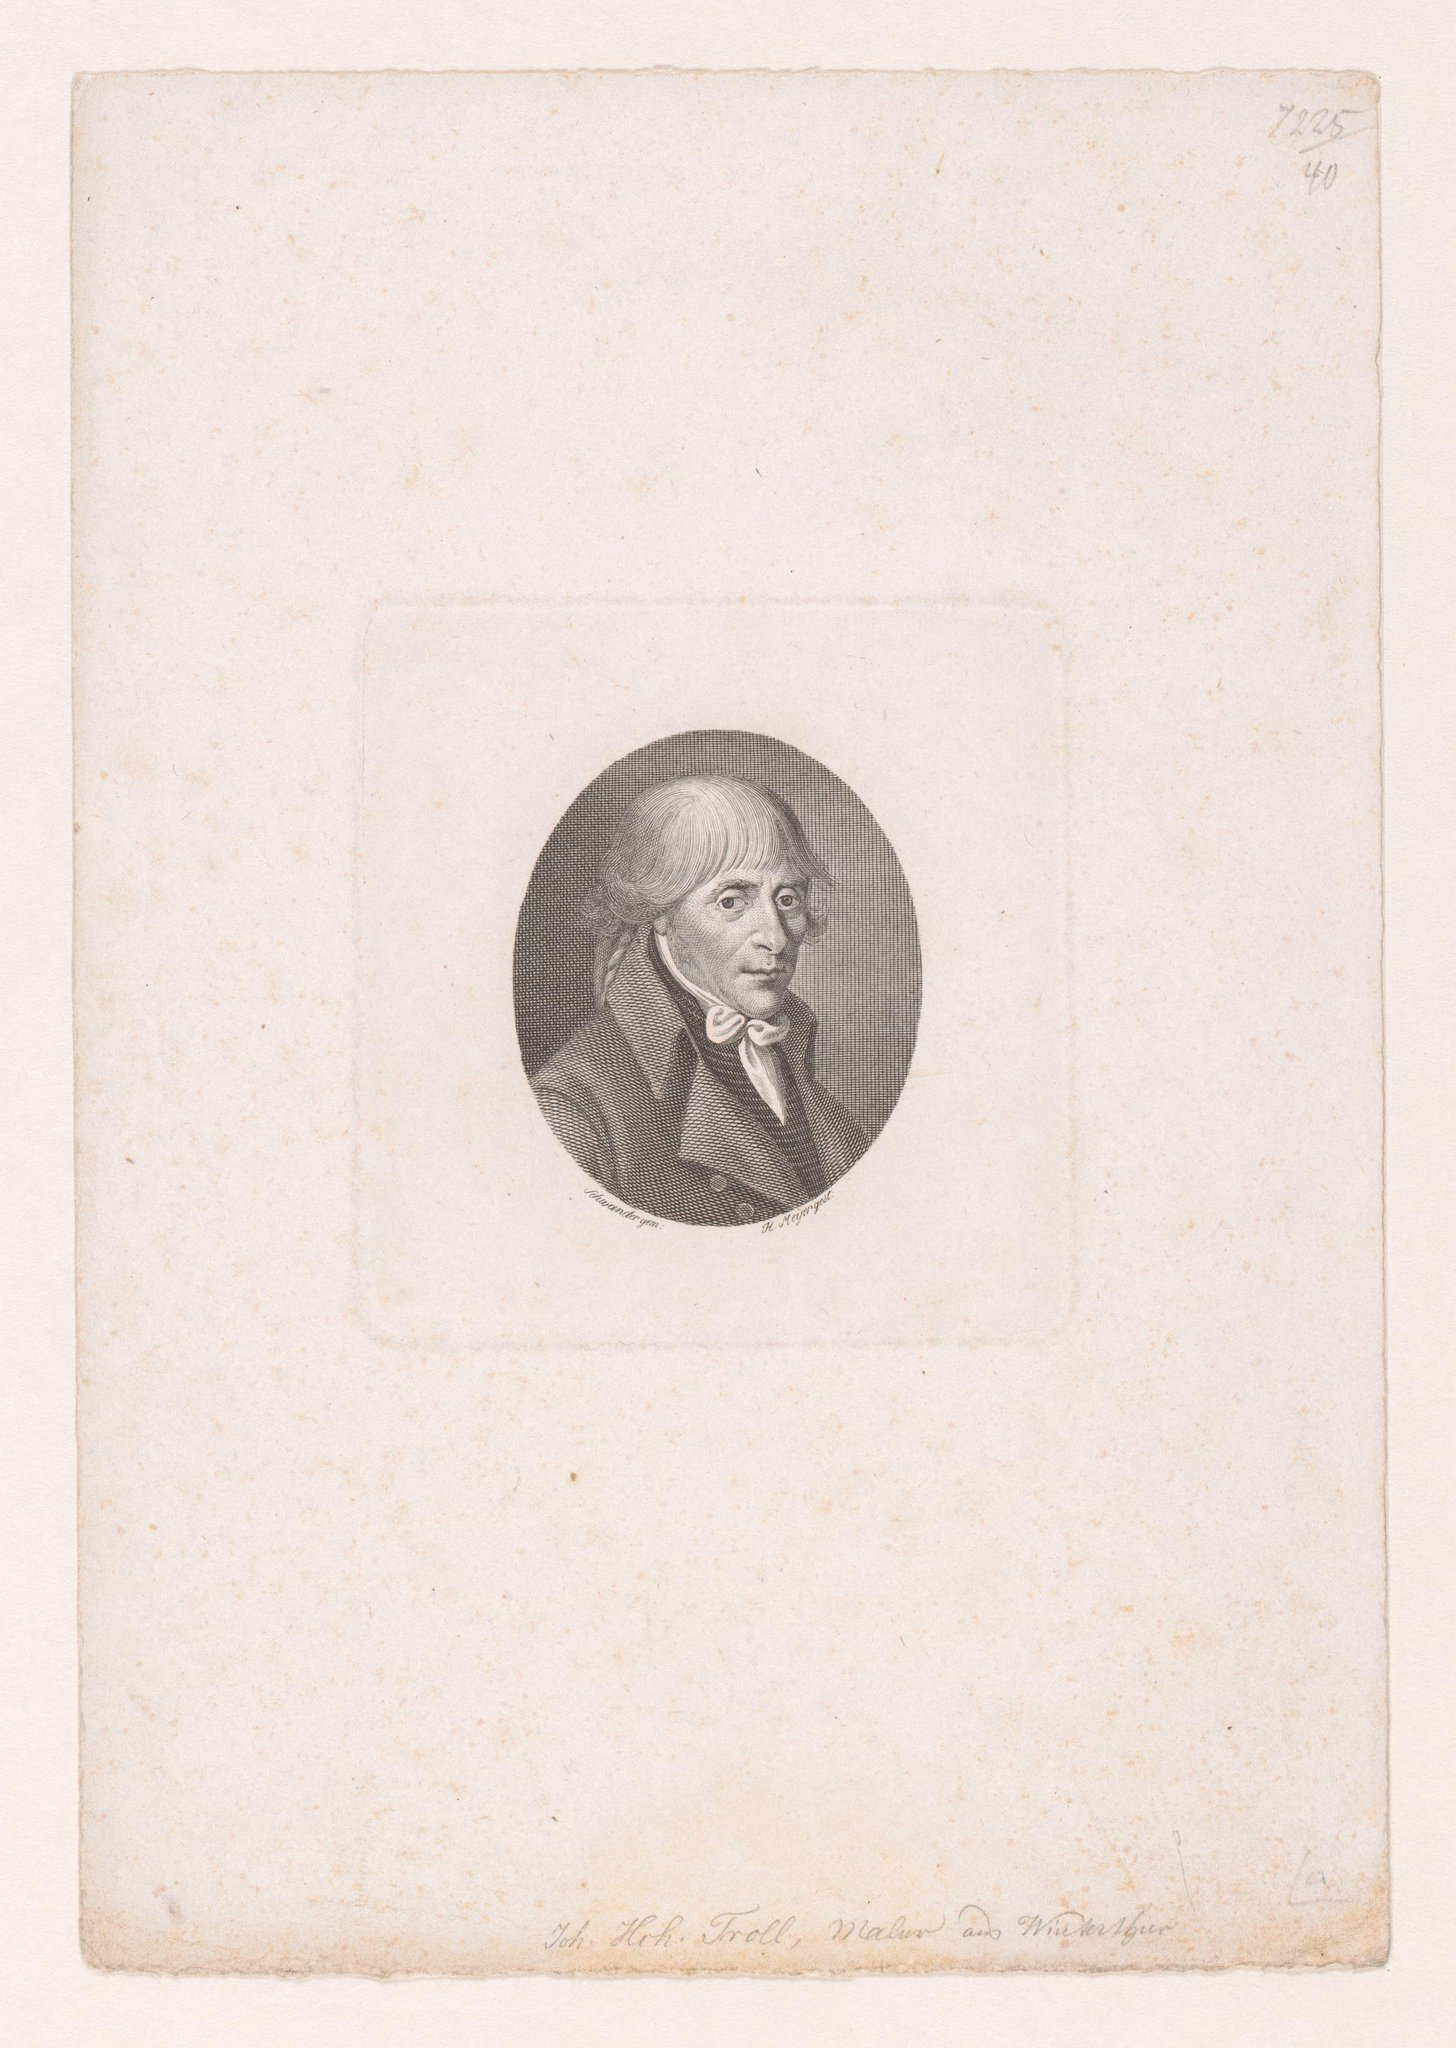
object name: print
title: Portret van een onbekende man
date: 1812-1877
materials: paper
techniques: engraving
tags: historical persons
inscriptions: name: ‘Joh. H(?). Troll, Maler aus Winterthur’, collector's mark: Lugt 2228